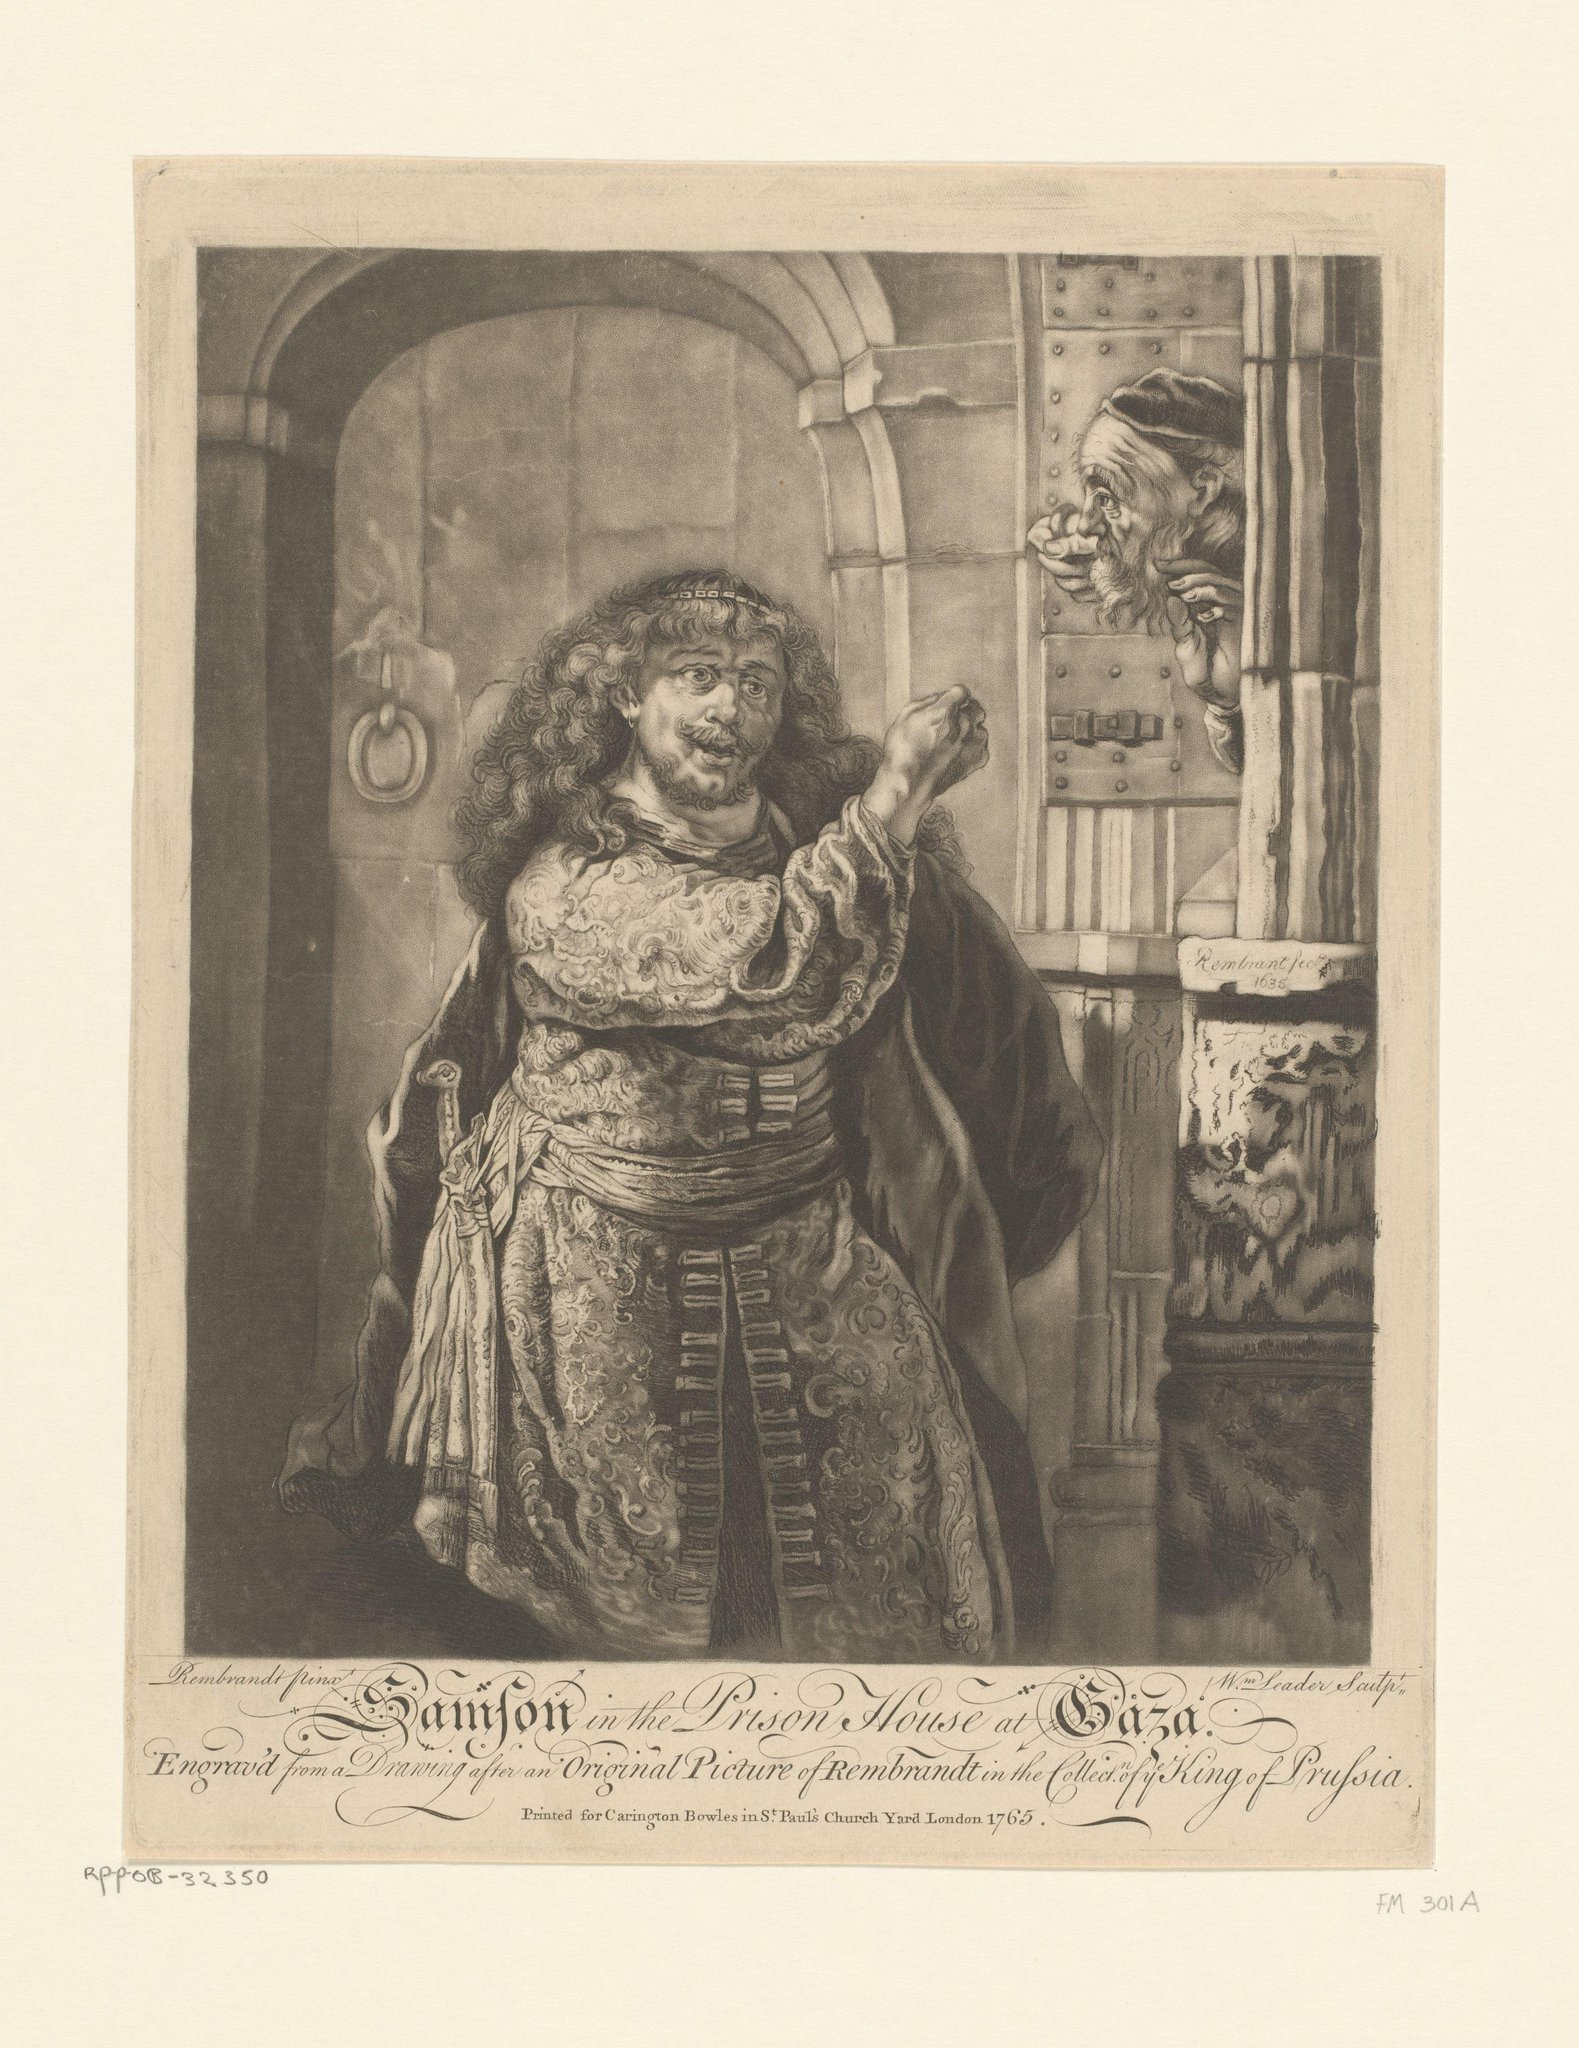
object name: history print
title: Simson bedreigt zijn schoonvader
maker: william leader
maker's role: print maker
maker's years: 1729-1765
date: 1765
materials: paper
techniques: etching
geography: london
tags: prison, jail, netherlands, burgundian netherlands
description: Simson bedreigt zijn schoonvader. Vroeger is deze voorstelling (ten onrechte) geïnterpreteerd als Adolf van Egmond, hertog van Gelre die zijn vader Arnold van Egmond, hertog van Gelre, die in de gevangenis zit, bedreigt.